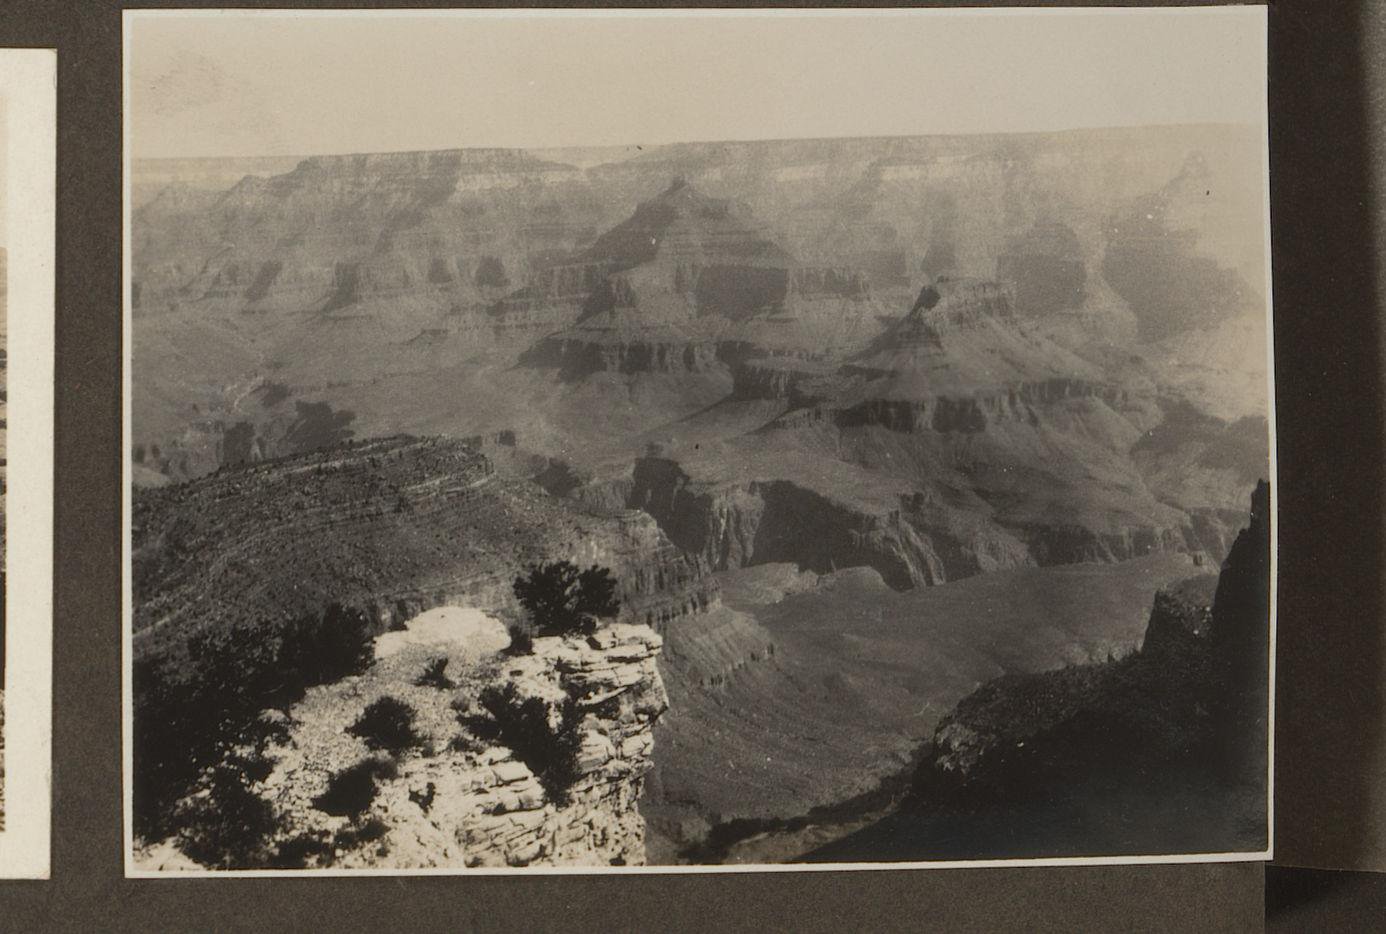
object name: album leaf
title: Gezicht op de Grand Canyon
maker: Anonymous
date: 1928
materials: photographic support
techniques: gelatin silver print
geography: grand canyon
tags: ravine, chasm, abyss, canyon, mountains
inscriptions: annotation: ‘Grand Canyon’